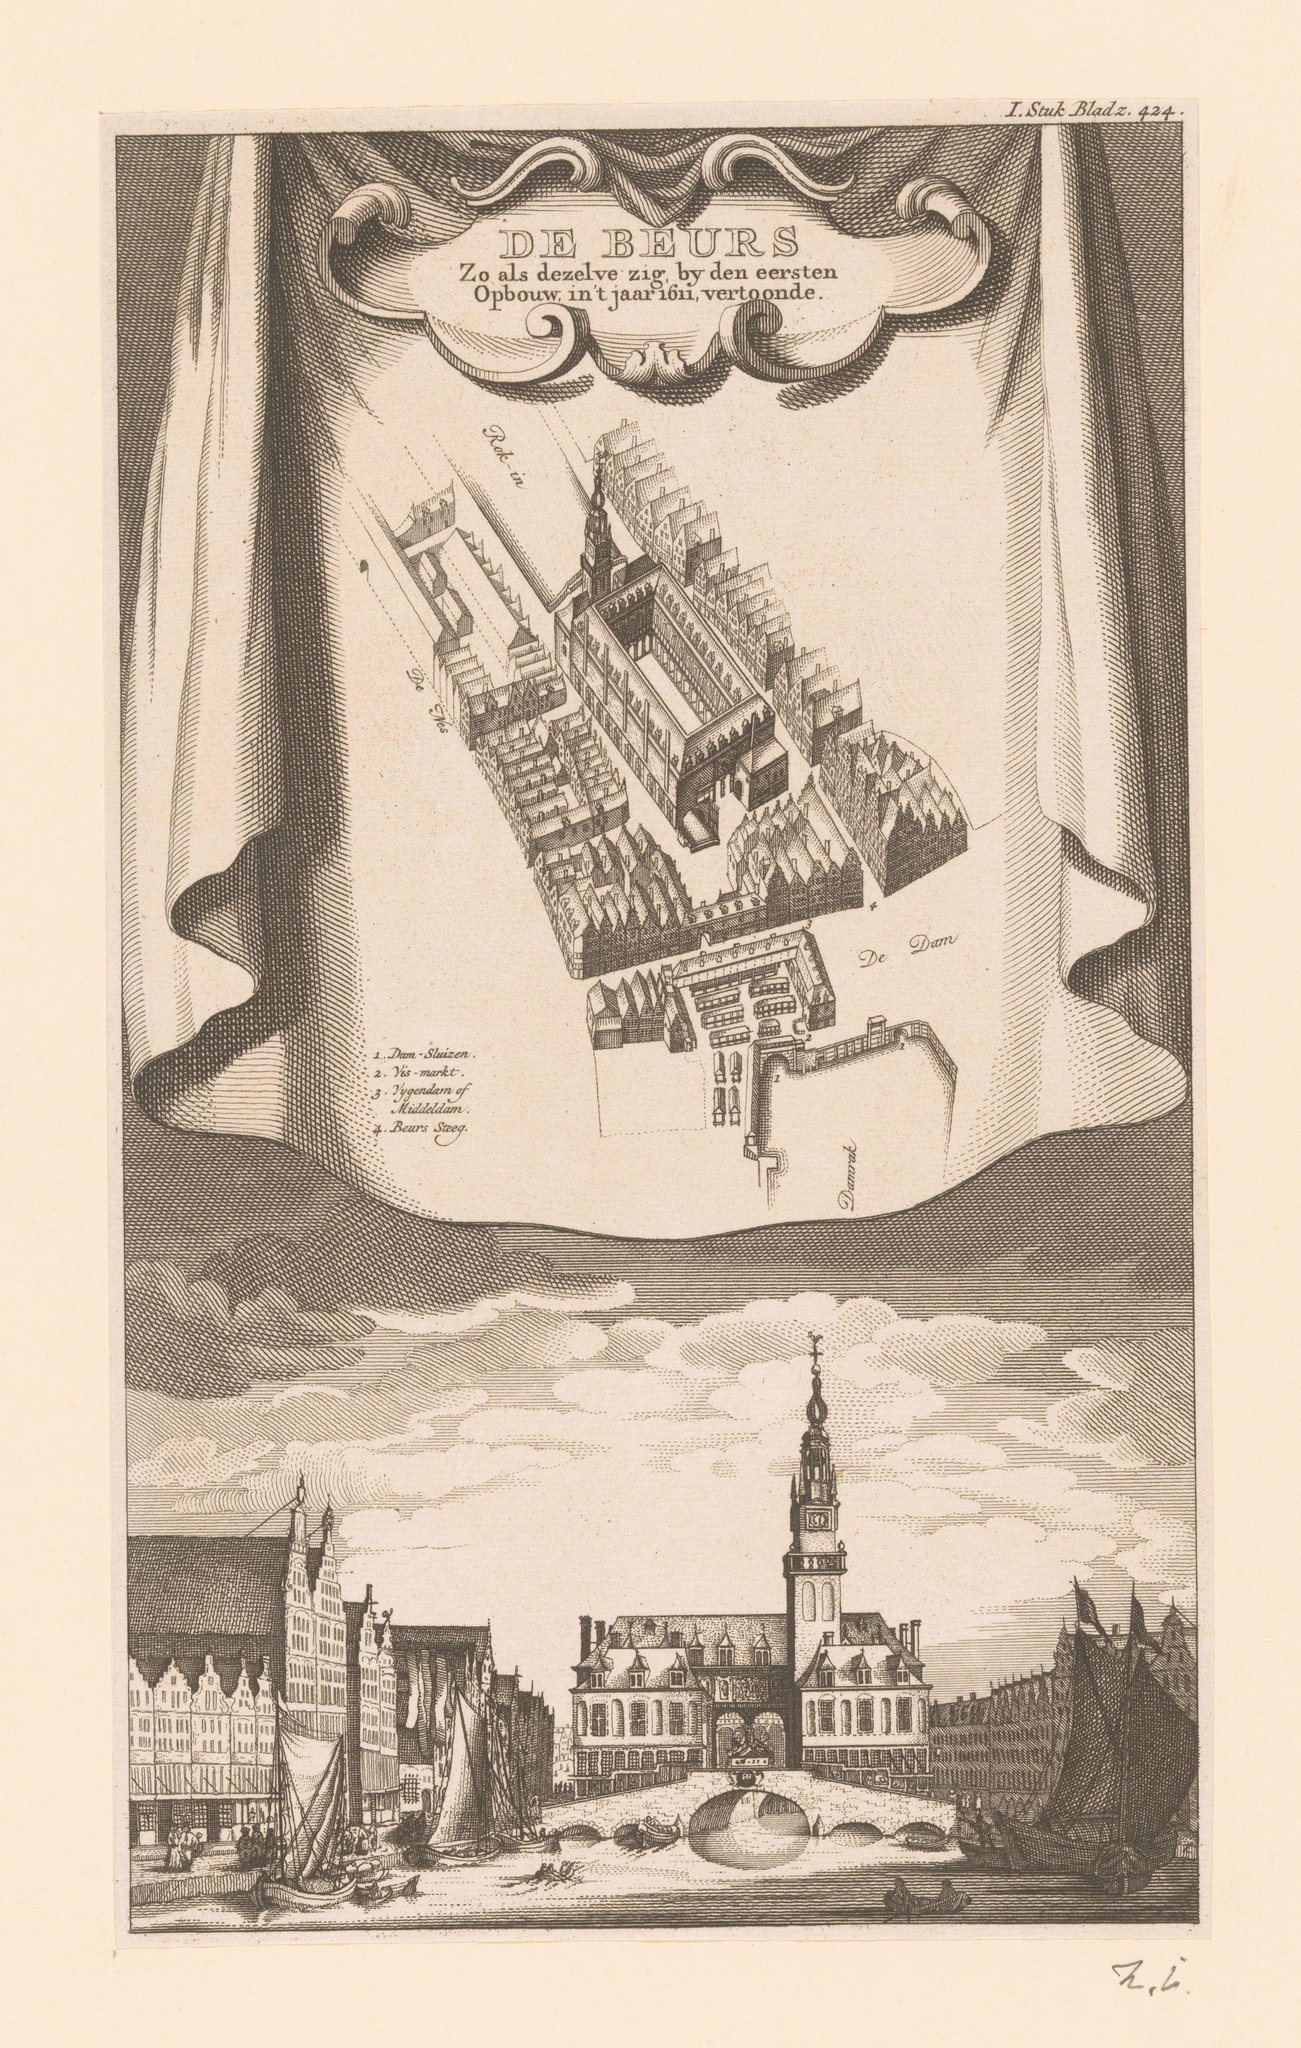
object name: book illustration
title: De Beurs Zo als dezelve zig, by den eersten Opbouw, in 't jaar 1611, vertoonde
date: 1760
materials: paper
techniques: engraving, etching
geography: amsterdam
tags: tower, clock tower ~ monumental adornment, stock exchange, stock-market, bridge in city across river, canal, etc.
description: Prent uit: Wagenaar, Jan. Amsterdam, in zyne opkomst, aanwas, geschiedenissen (...). 2 dln. Amsterdam: Isaak Tirion, 1760, dl. 1, p. 424.